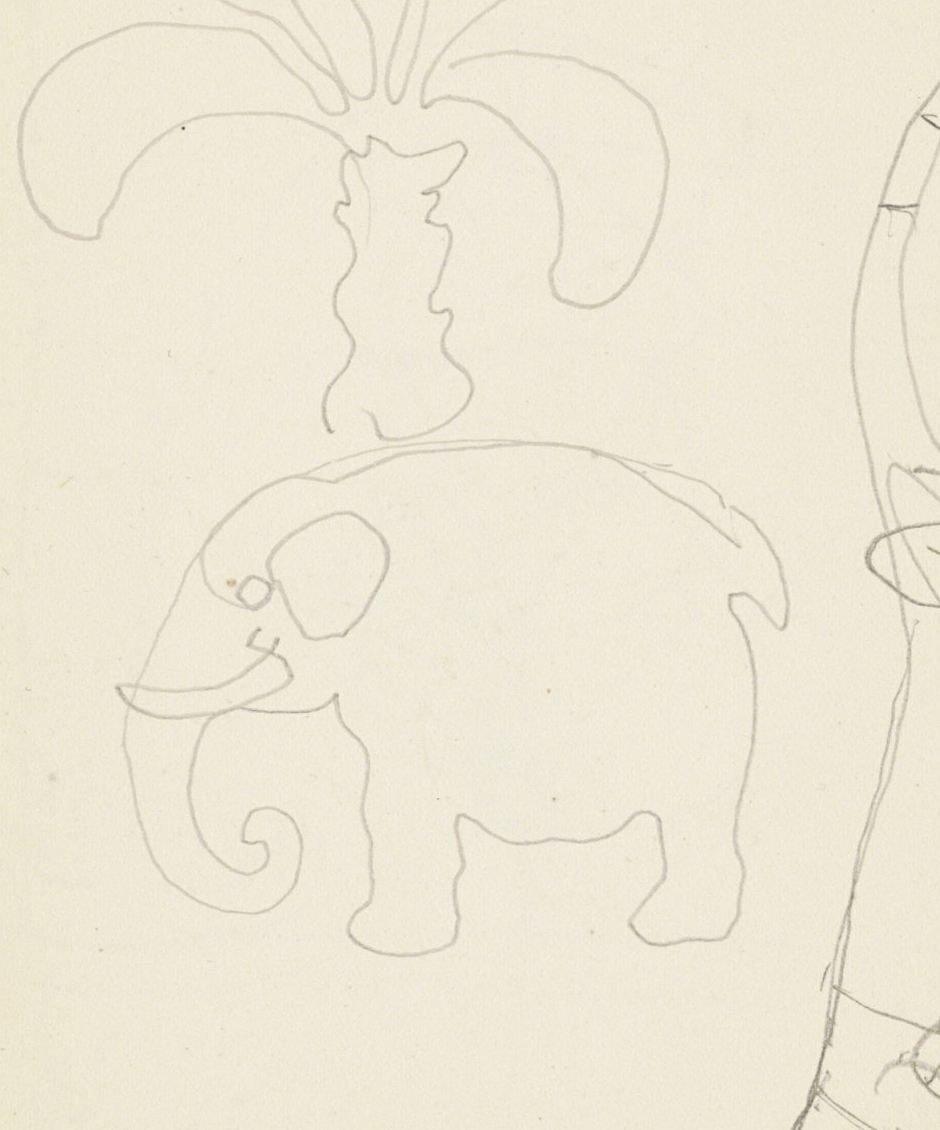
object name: sketchbook leaf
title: Palmboom, een olifant en een gekko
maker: reijer stolk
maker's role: draughtsman, print maker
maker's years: 1896-1945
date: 1916-1945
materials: paper, pencil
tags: reptiles, trees: palm-tree, trunked animals: elephant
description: Blad 5 recto uit een schetsboek met 60 bladen.